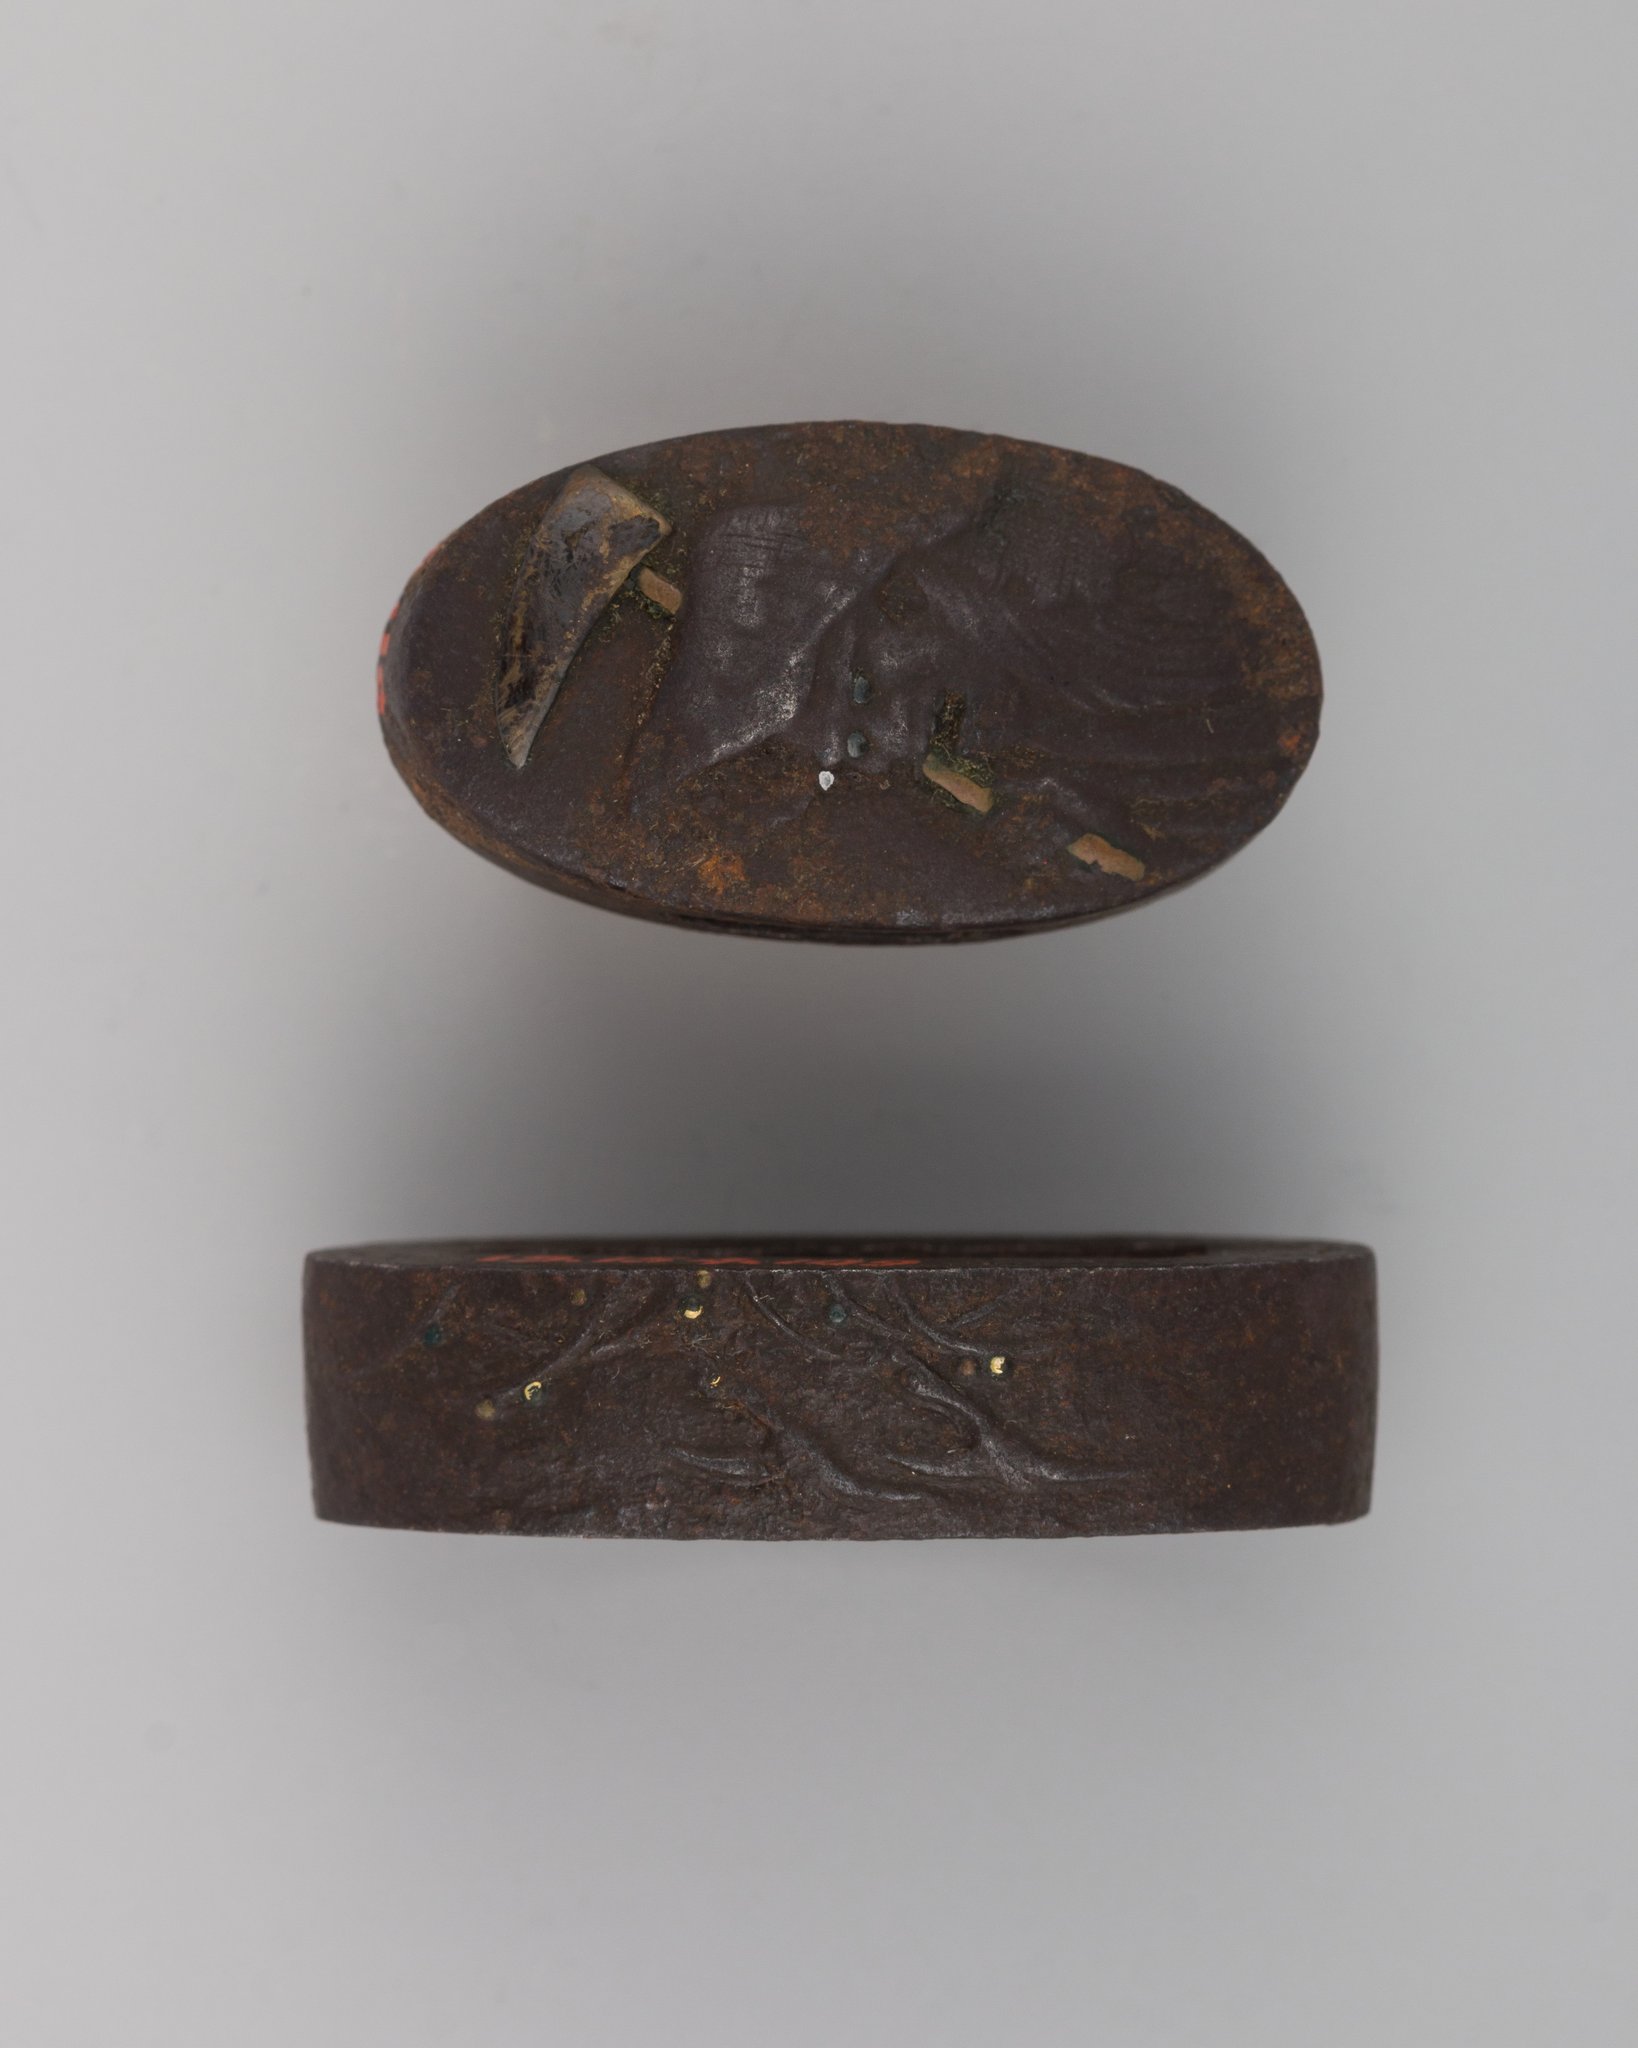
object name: sword pommel kashira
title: Sword Pommel (Kashira)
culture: japanese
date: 1615-1868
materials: silver alloy, gold, iron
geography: japan